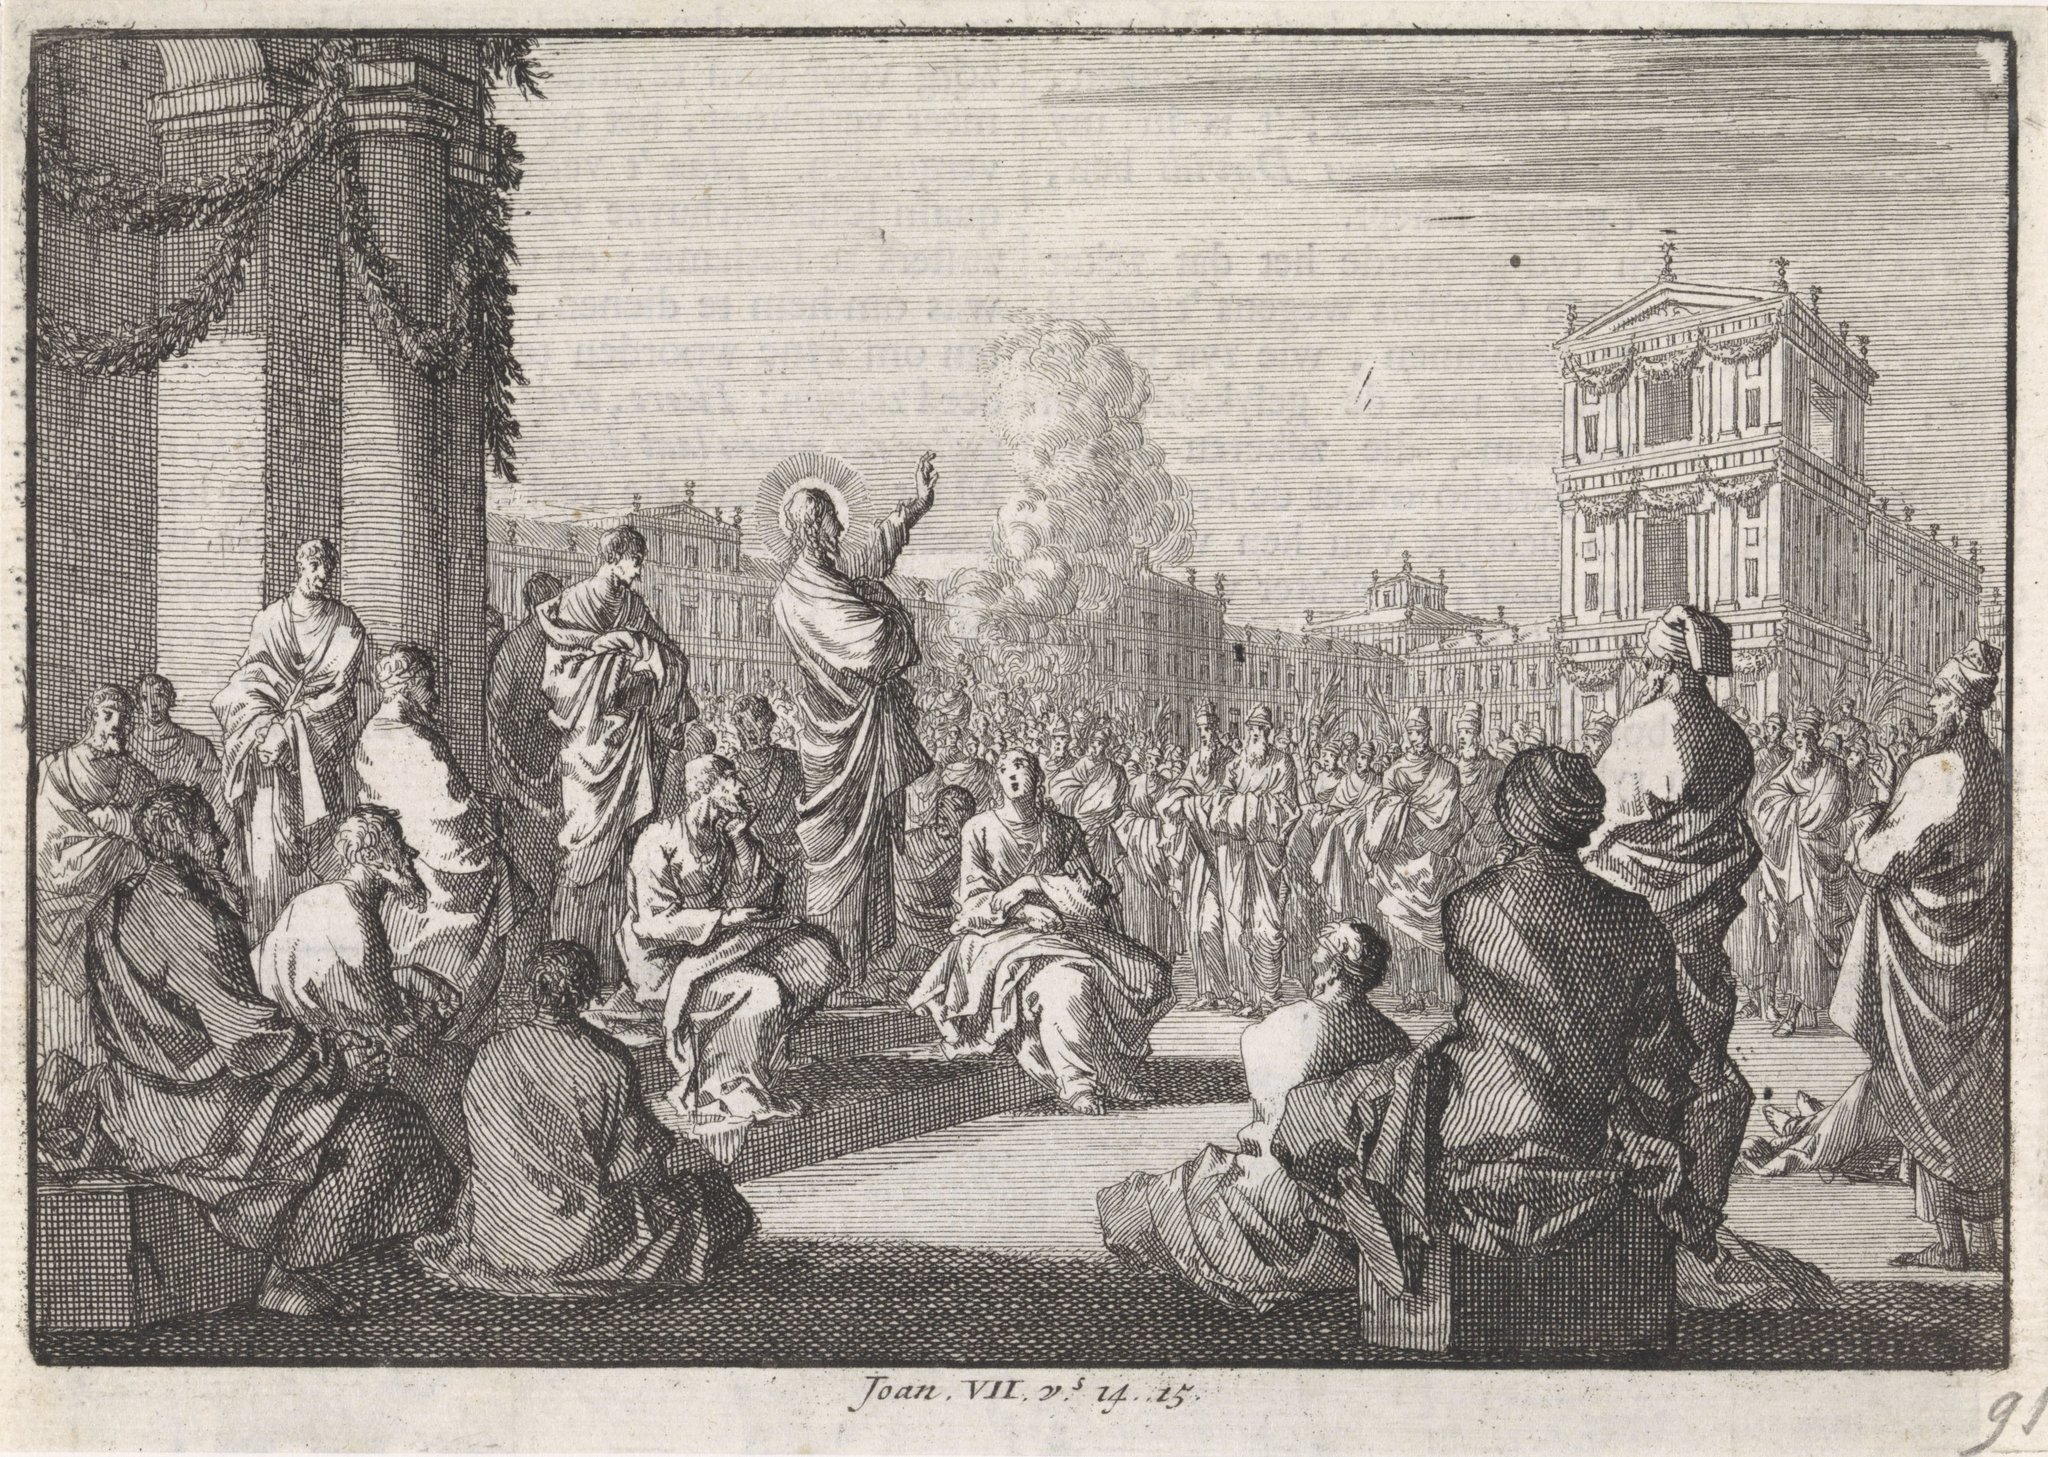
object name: print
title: Preek van Christus voor de tempel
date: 1703-1762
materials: paper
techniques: etching, letterpress printing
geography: amsterdam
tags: christ is teaching in the temple in the middle of the feast of tabernacles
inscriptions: collector's mark: Lugt 2228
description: De prent komt een eerste keer voor als boekillustratie voor David Martin. Historie des Ouden en Nieuwen Testaments. Amsterdam, Pieter Mortier, 1703. Deel II. De boekillustraties voor de Mortierbijbel hebben verschillende staten en kopieën, waarbij de chronologische volgorde moeilijk te achterhalen valt. Als boekillustraties werden ze bovendien herhaaldelijk opnieuw gebruikt voor andere boekwerken.